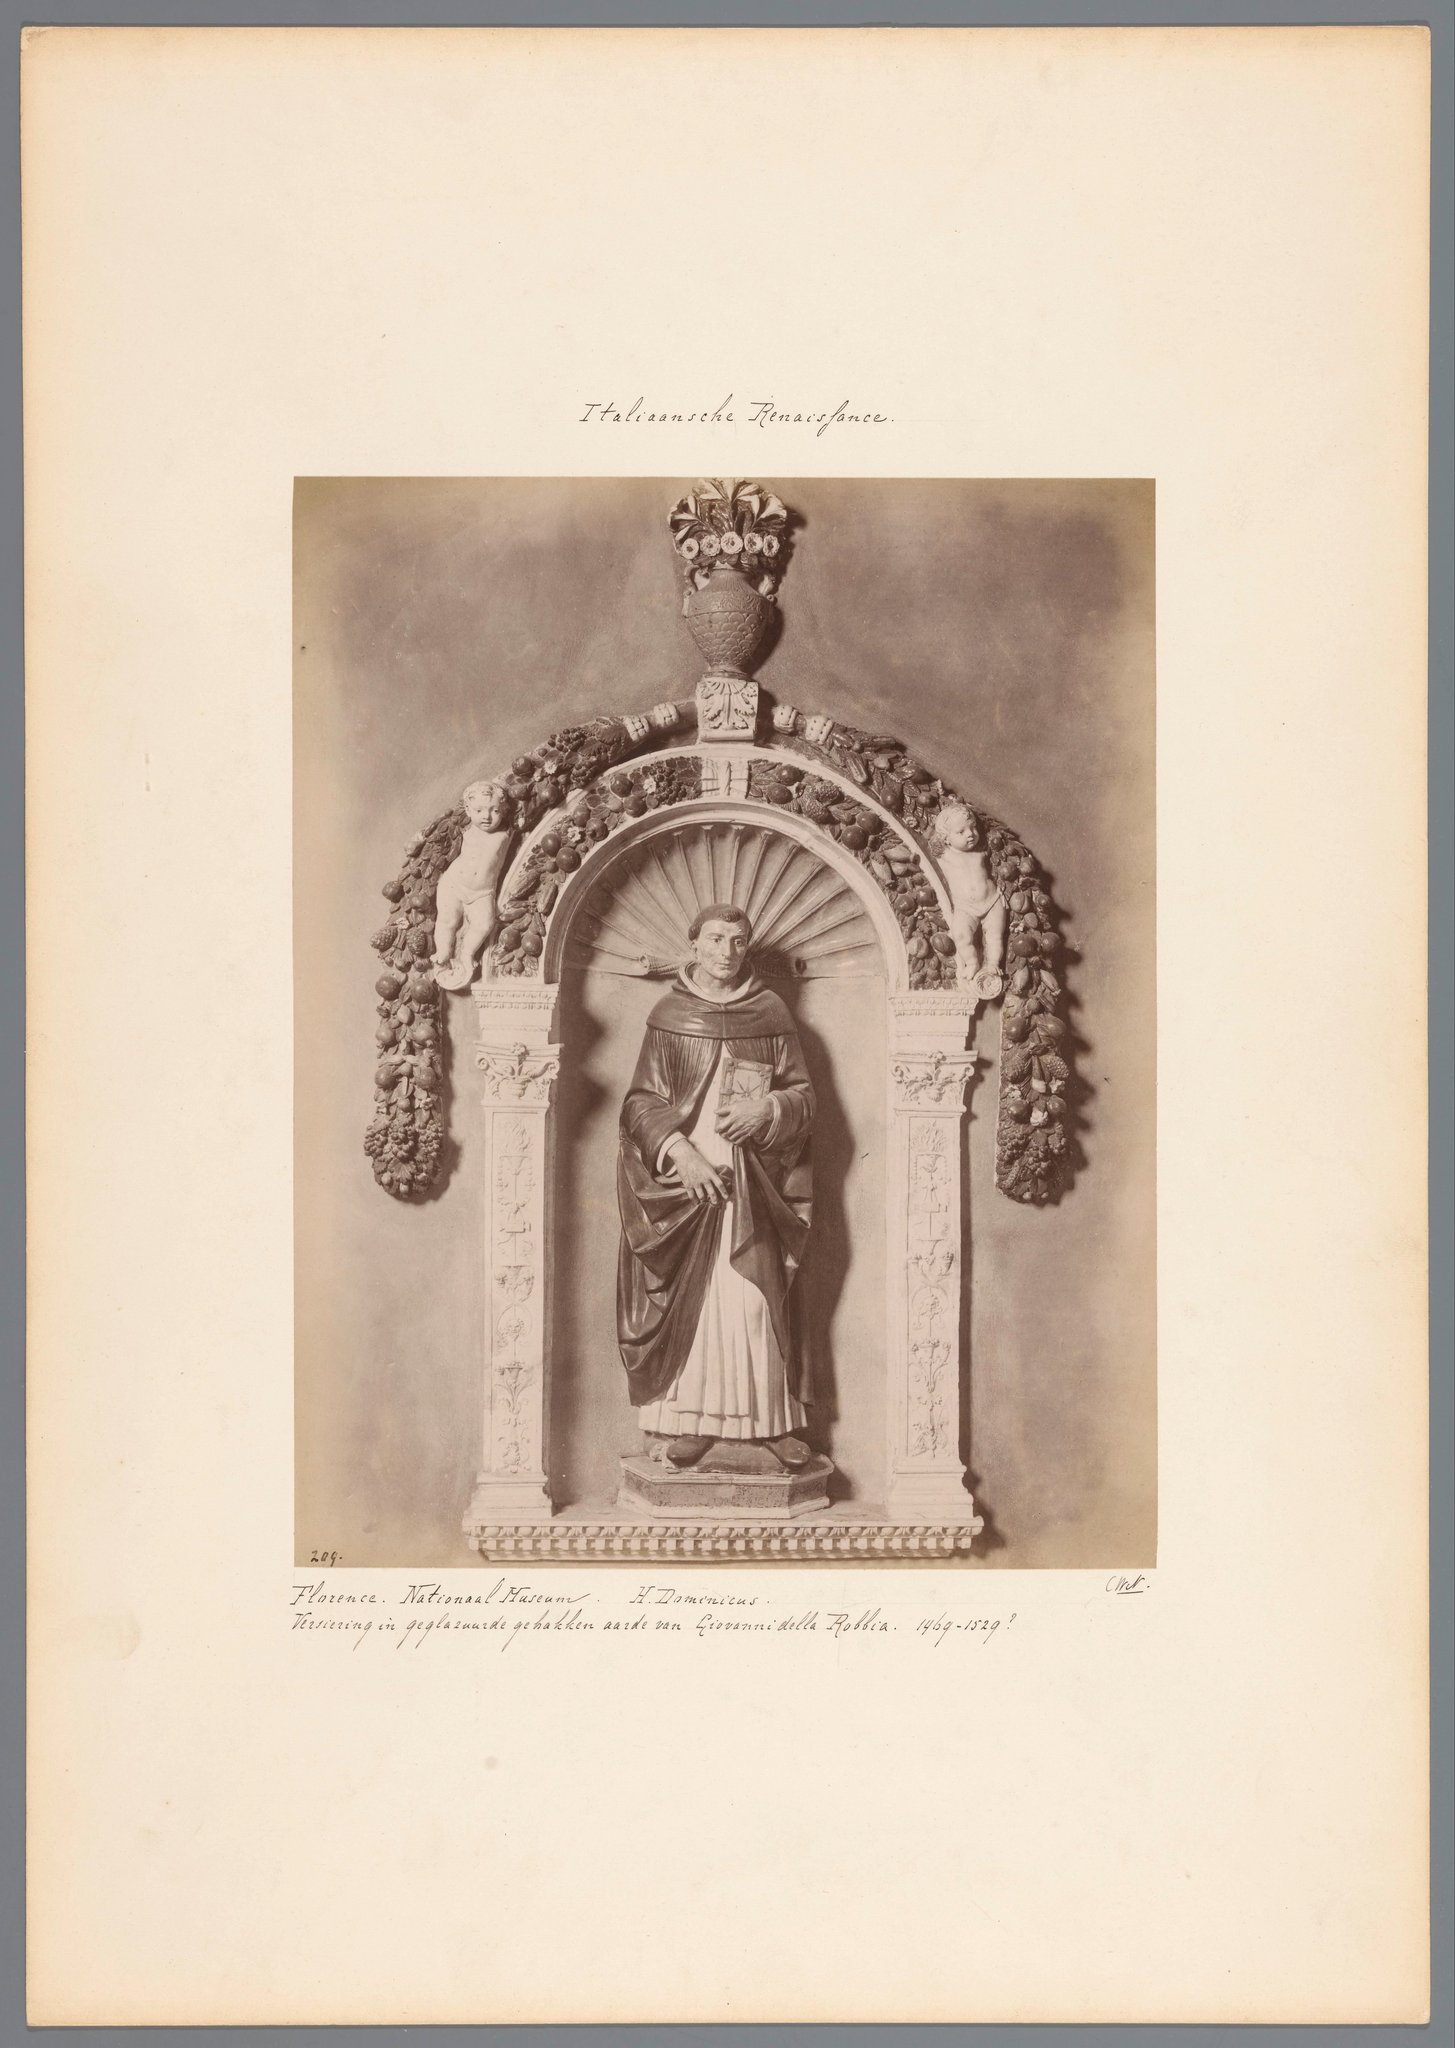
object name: photograph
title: Florence. Nationaal Museum. H. Dominicus.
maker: Anonymous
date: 1875-1900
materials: cardboard, photographic support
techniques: albumen print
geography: europe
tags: dominic(us) guzman of calerueja, founder of the order of preachers (or dominican (black) friars; possible attributes: book, dog with flaming torch, lily, loaf of bread, rosary, star, sculpture (+ relief ~ sculpture)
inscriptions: number: ‘209.’, inscription: ‘KUNSTNIJVERHEIDSCHOOL QUELLINUS AMSTERDAM FRANS HALSSTRAAT 14.’, collector's mark: ‘INSTITUUT VOOR KUNST-NIJVERHEIDSONDERWIJS GABRIËL METSUSTRAAT No. 16 AMSTERDAM’, inscription: ‘Italiaansche Renaissance.’, inscription: ‘CWN.’